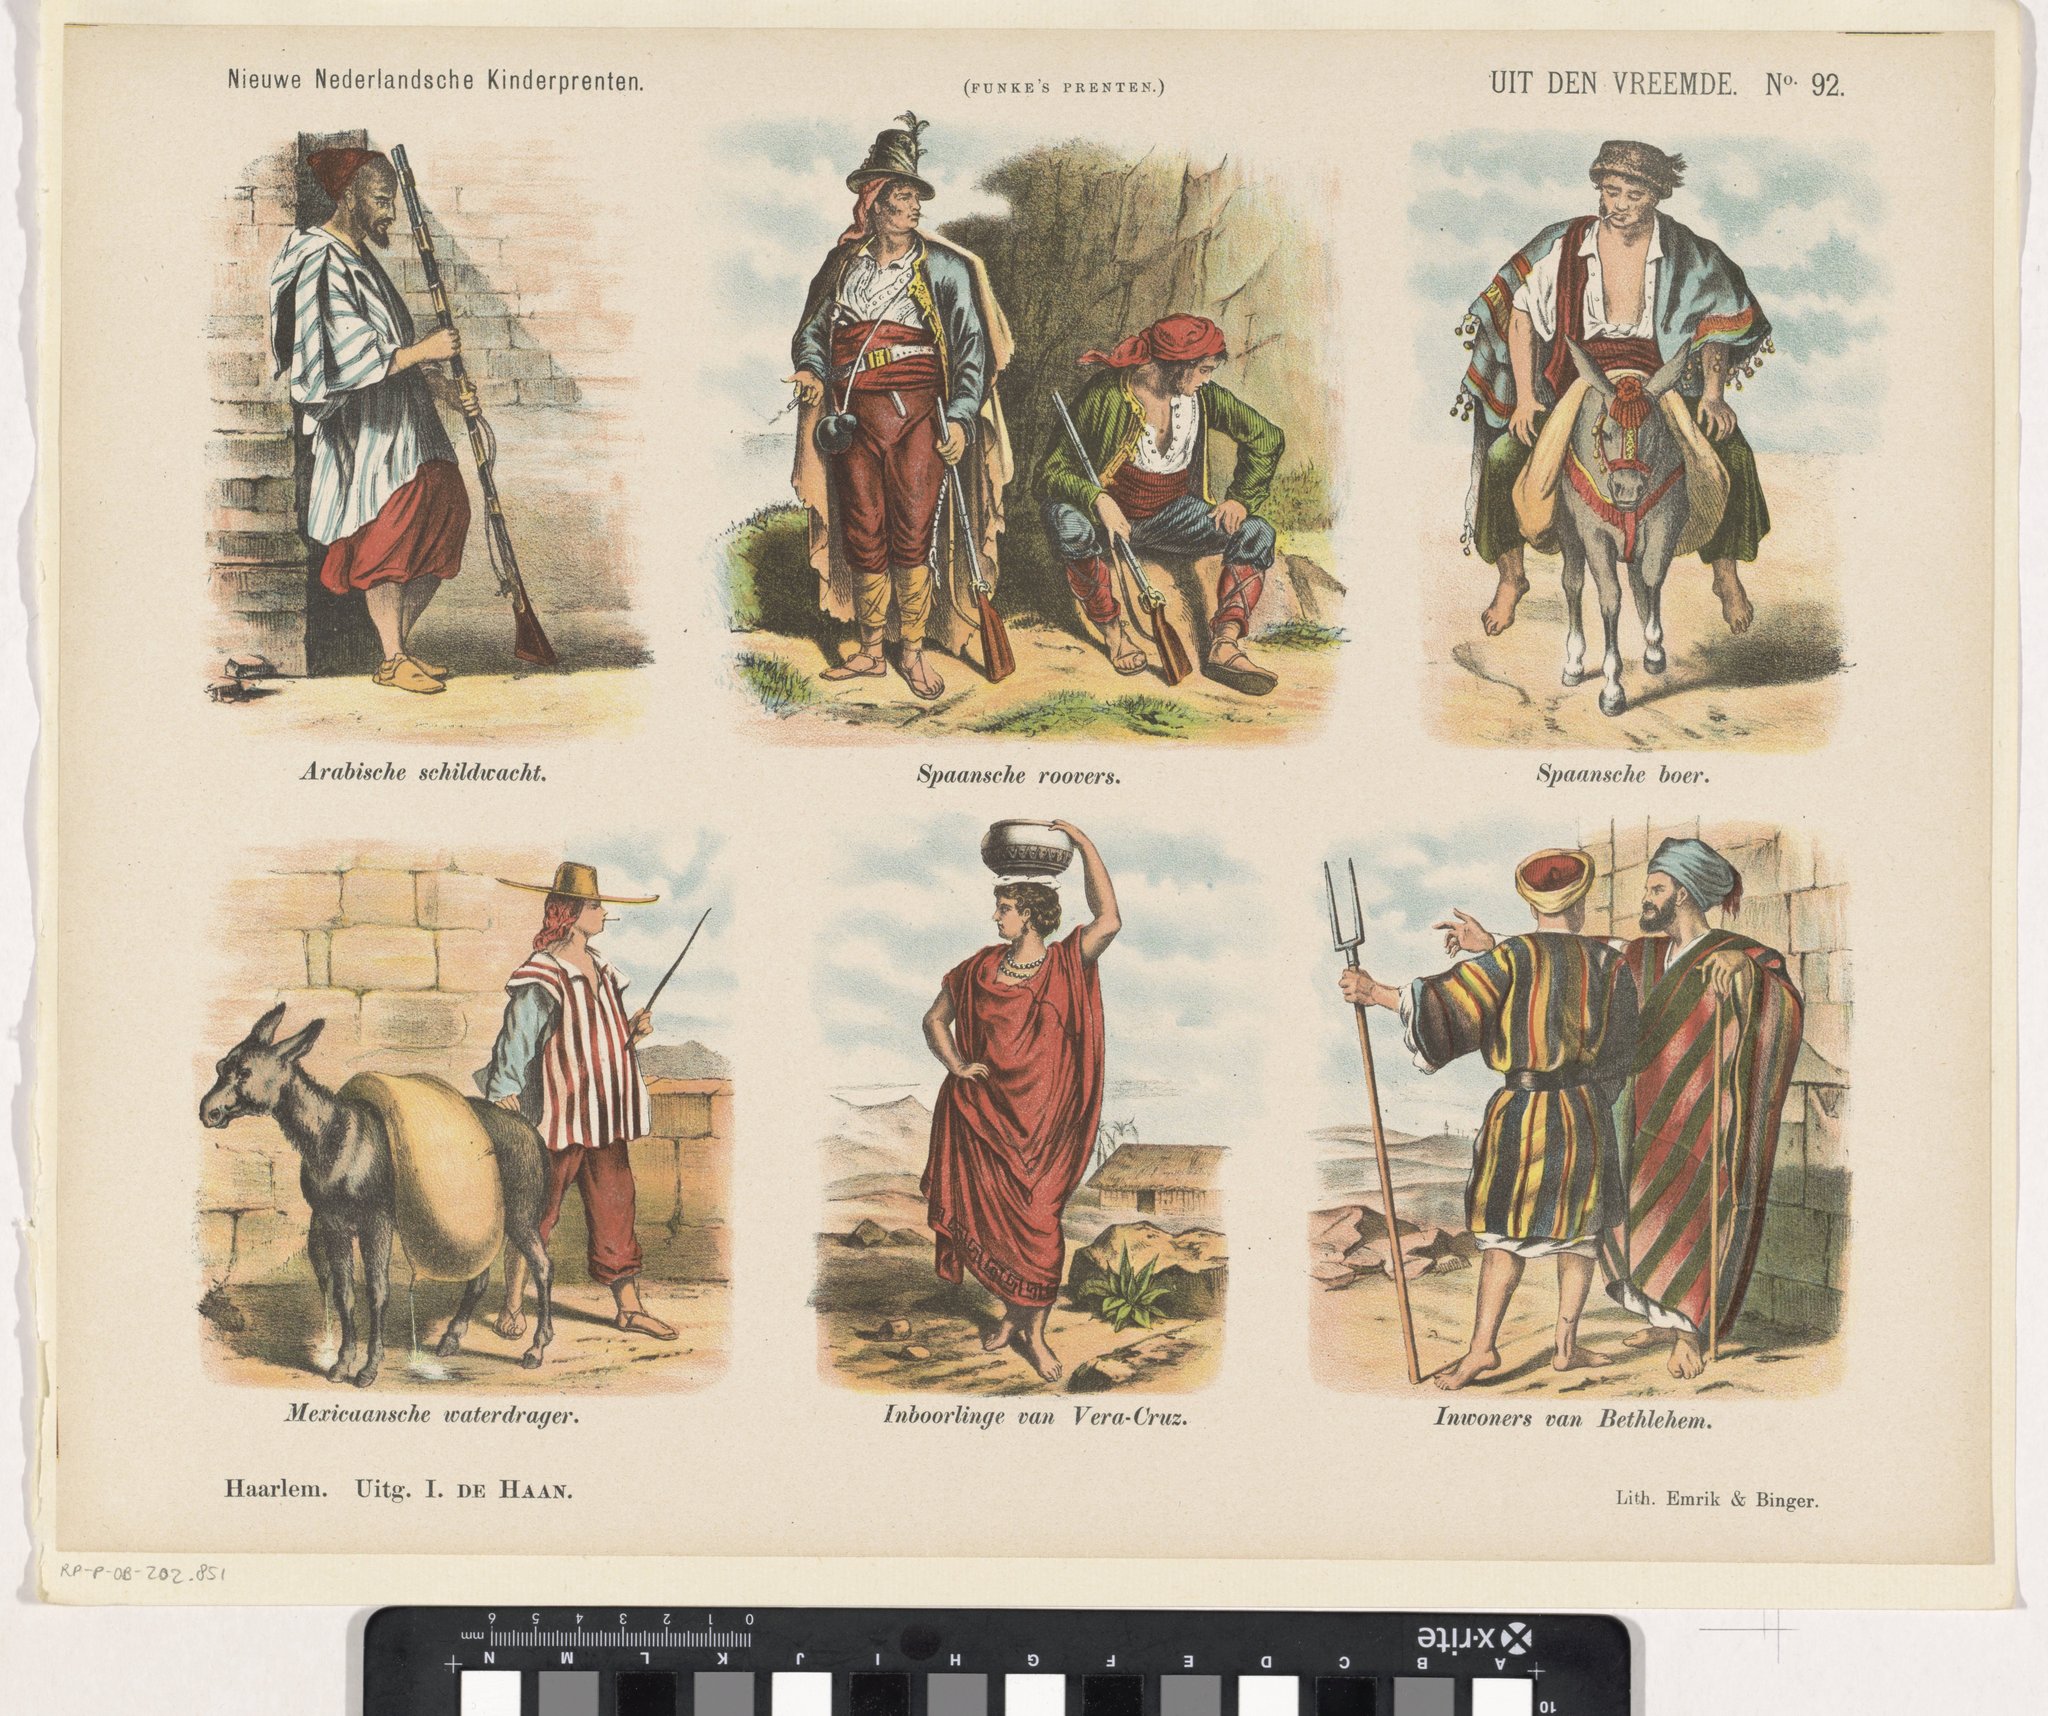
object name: print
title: Nieuwe Nederlandsche kinderprenten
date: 1875-1903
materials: paper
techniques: lithograph, letterpress printing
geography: haarlem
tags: robber, farmers, characters (human types)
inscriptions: collector's mark: Lugt 2760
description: Blad met 6 voorstellingen van figuren uit verschillende delen van de wereld, zoals een Arabische schildwacht, een Spaanse rover en een Mexicaanse waterdrager. Onder elke afbeelding een onderschrift. Genummerd rechtsboven: No. 92.